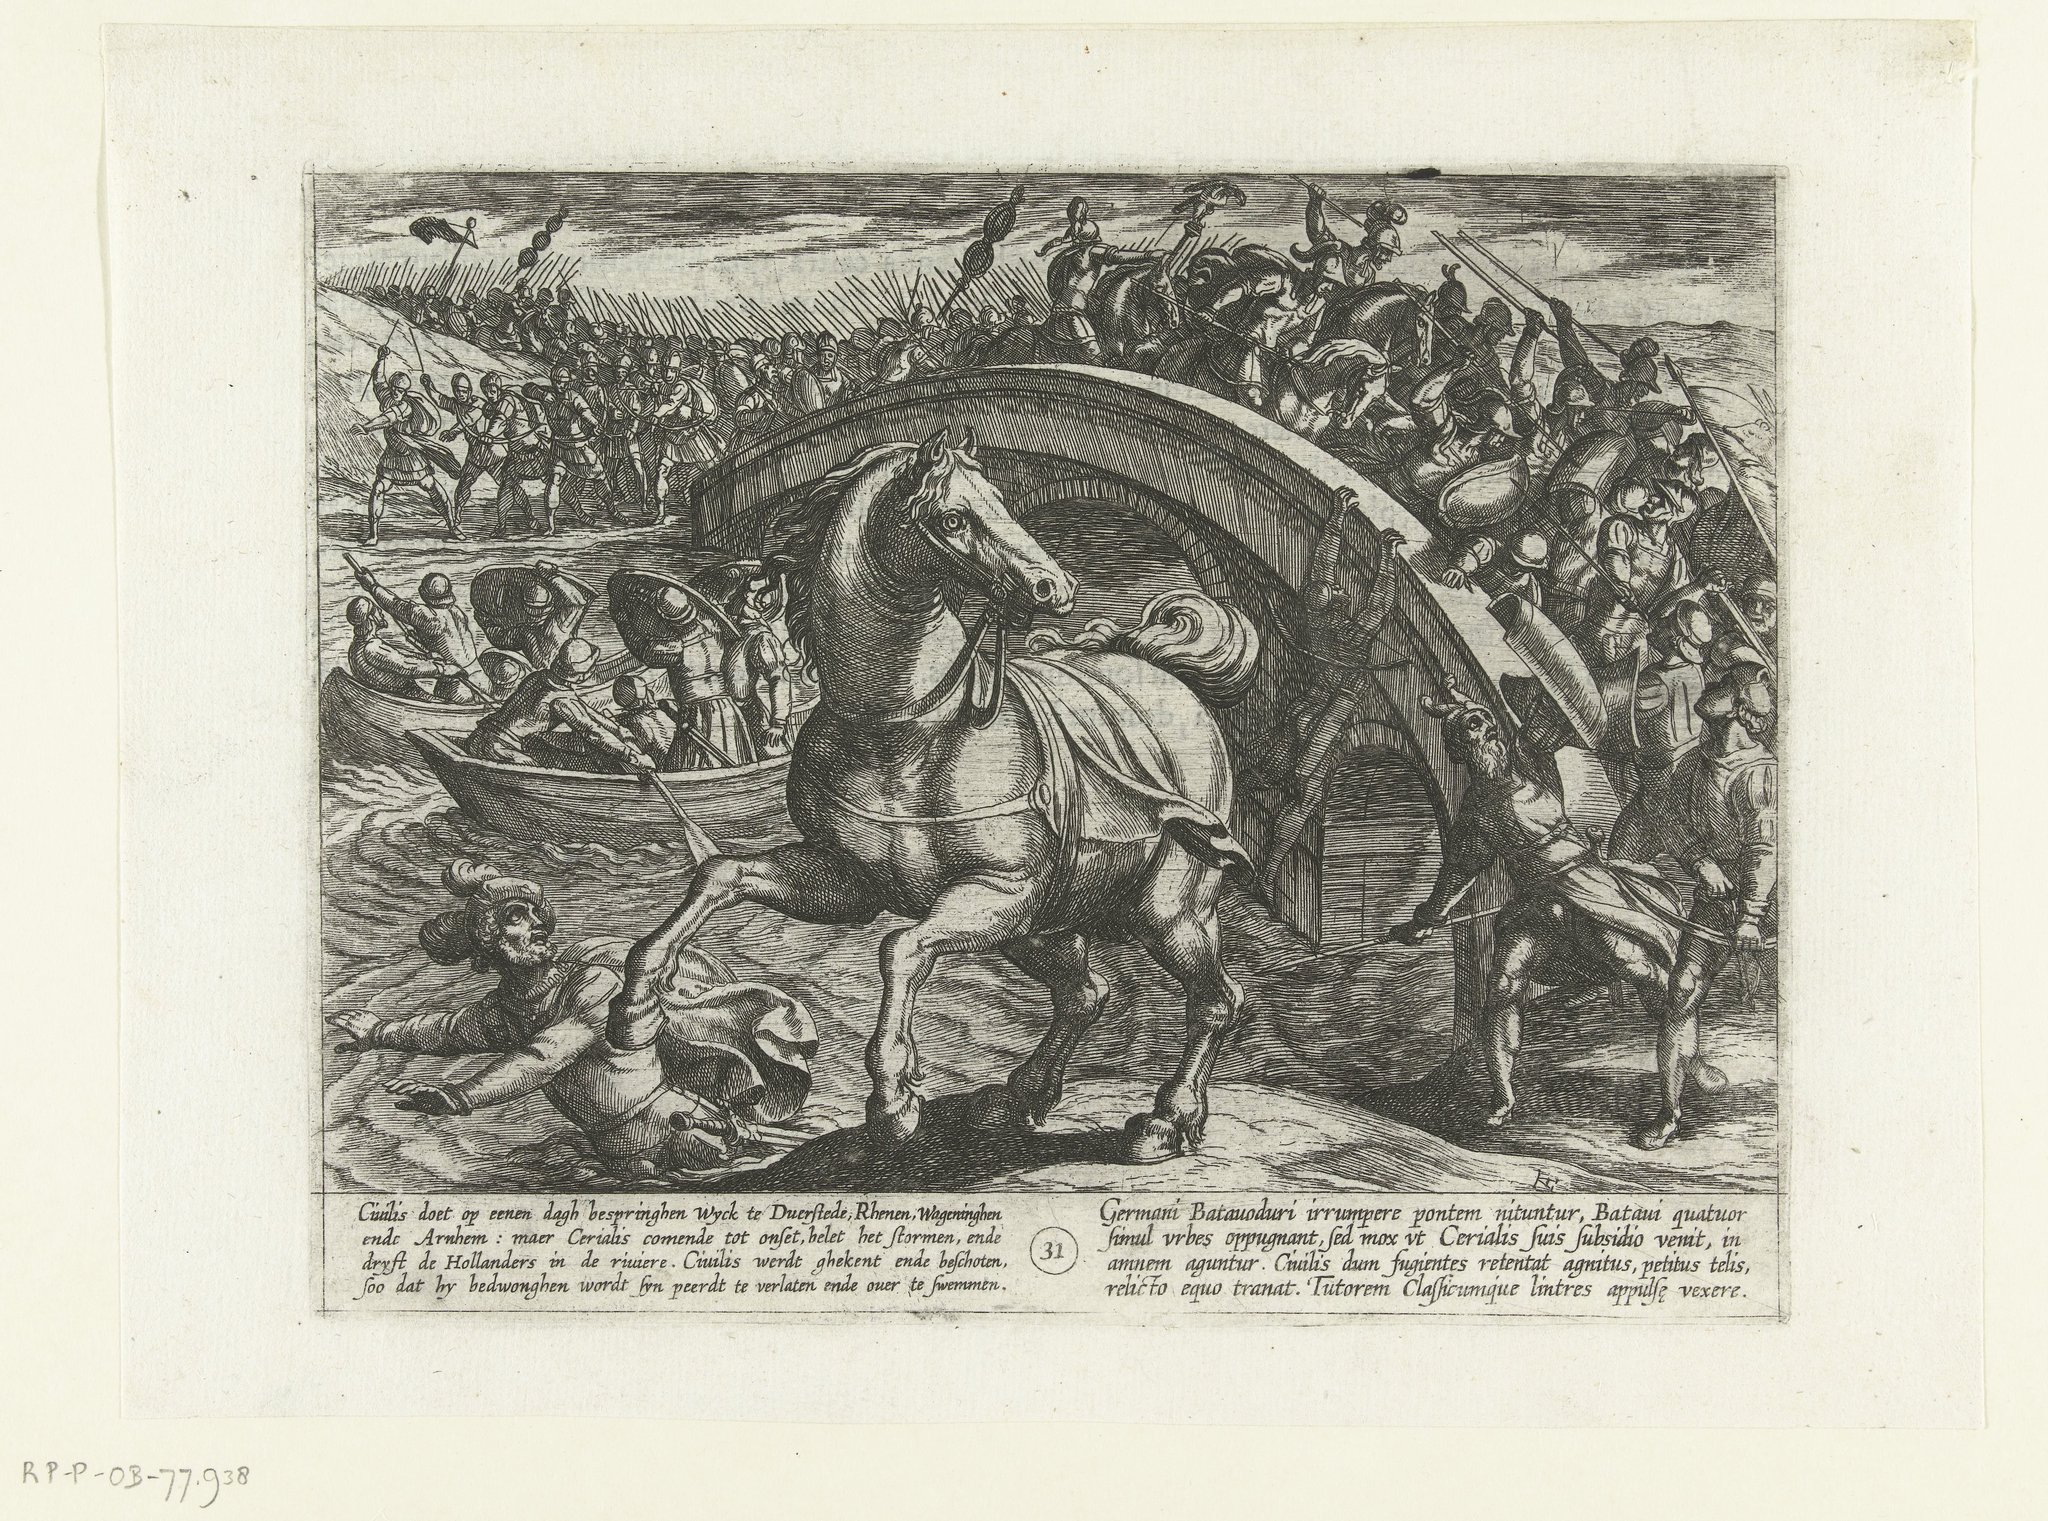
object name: history print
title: Batavorum cum Romanis Bellum, à Corn. Tacito / De Batavische Oft Oude Hollandtsche Oorloghe teghen de Romeynen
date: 1612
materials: paper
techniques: etching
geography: italy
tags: battle, fighting in general, extinct, 'historical' peoples (with name), netherlands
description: Civilis wordt herkend en beschoten en moet van zijn paard af en zwemmend vluchten. Prent nummer 31 in de serie prenten over de Bataafse Opstand: Batavorum cum Romanis bellum / à Corn. Tacito lib. IV & V. : Hist. olim descriptum, figuris nunc aeneis expressum, auctore Othone Vaenio Lugdunobatava = De Batavische oft oude Hollandtsche oorloghe teghen de Romeynen. Otto Vaenius, Antwerpen 1612. Onderaan twee verzen van vier regels in het Nederlands en in het Latijn. Op de achterzijde tekst in het Latijn.